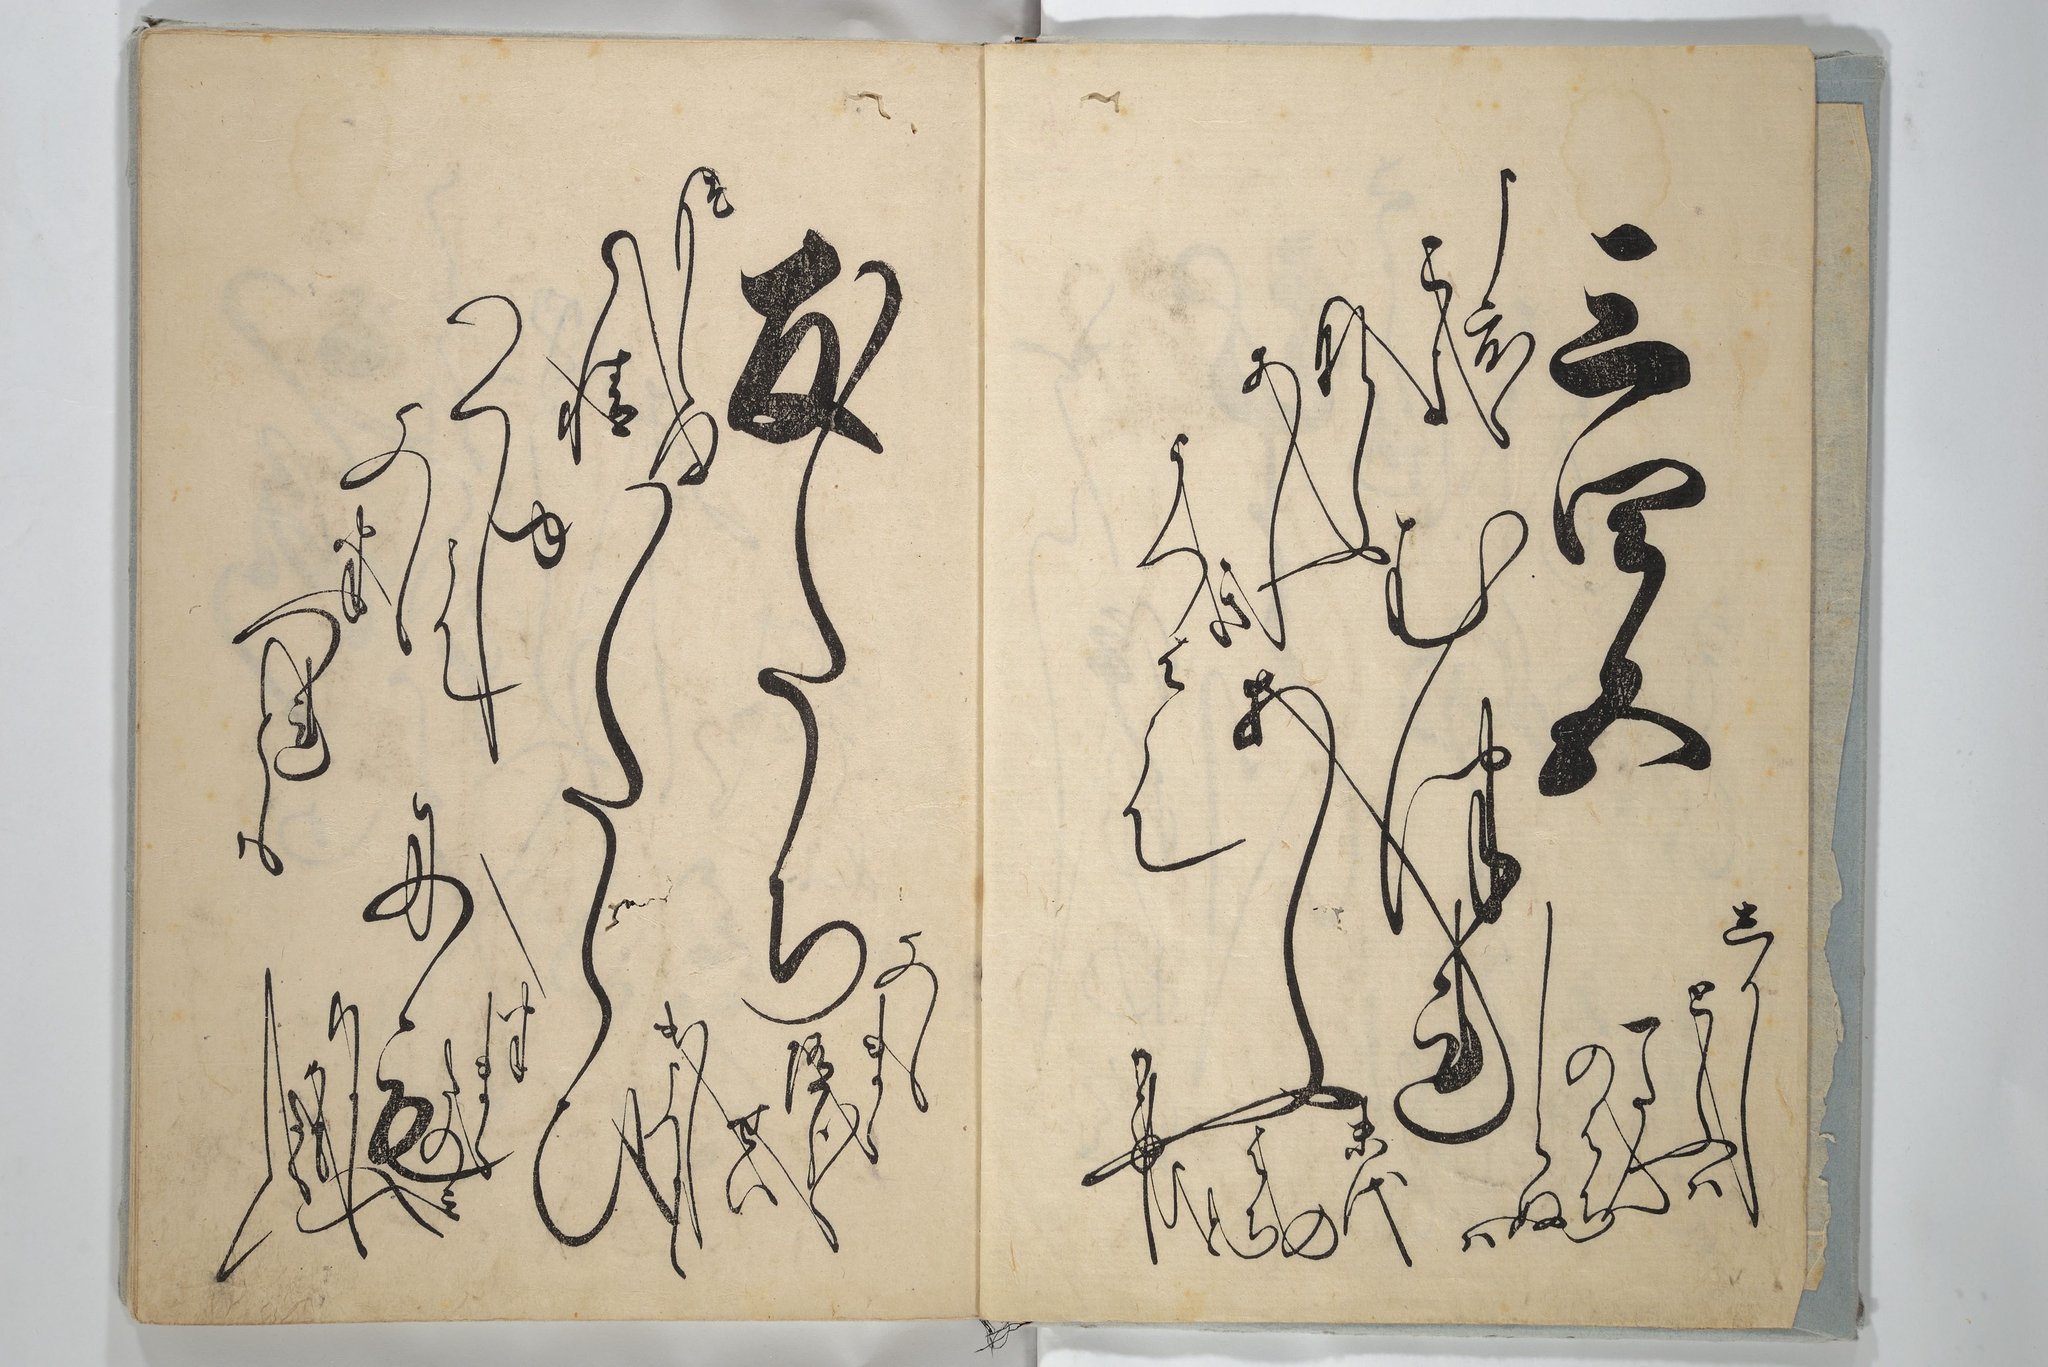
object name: illustrated book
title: A Calligraphy Book (Nani wazu) 難波津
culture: japanese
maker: hasegawa myōtei 長谷川妙躰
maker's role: artist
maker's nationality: japanese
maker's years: 1667-1699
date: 1714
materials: ink, paper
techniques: woodblock print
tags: calligraphy